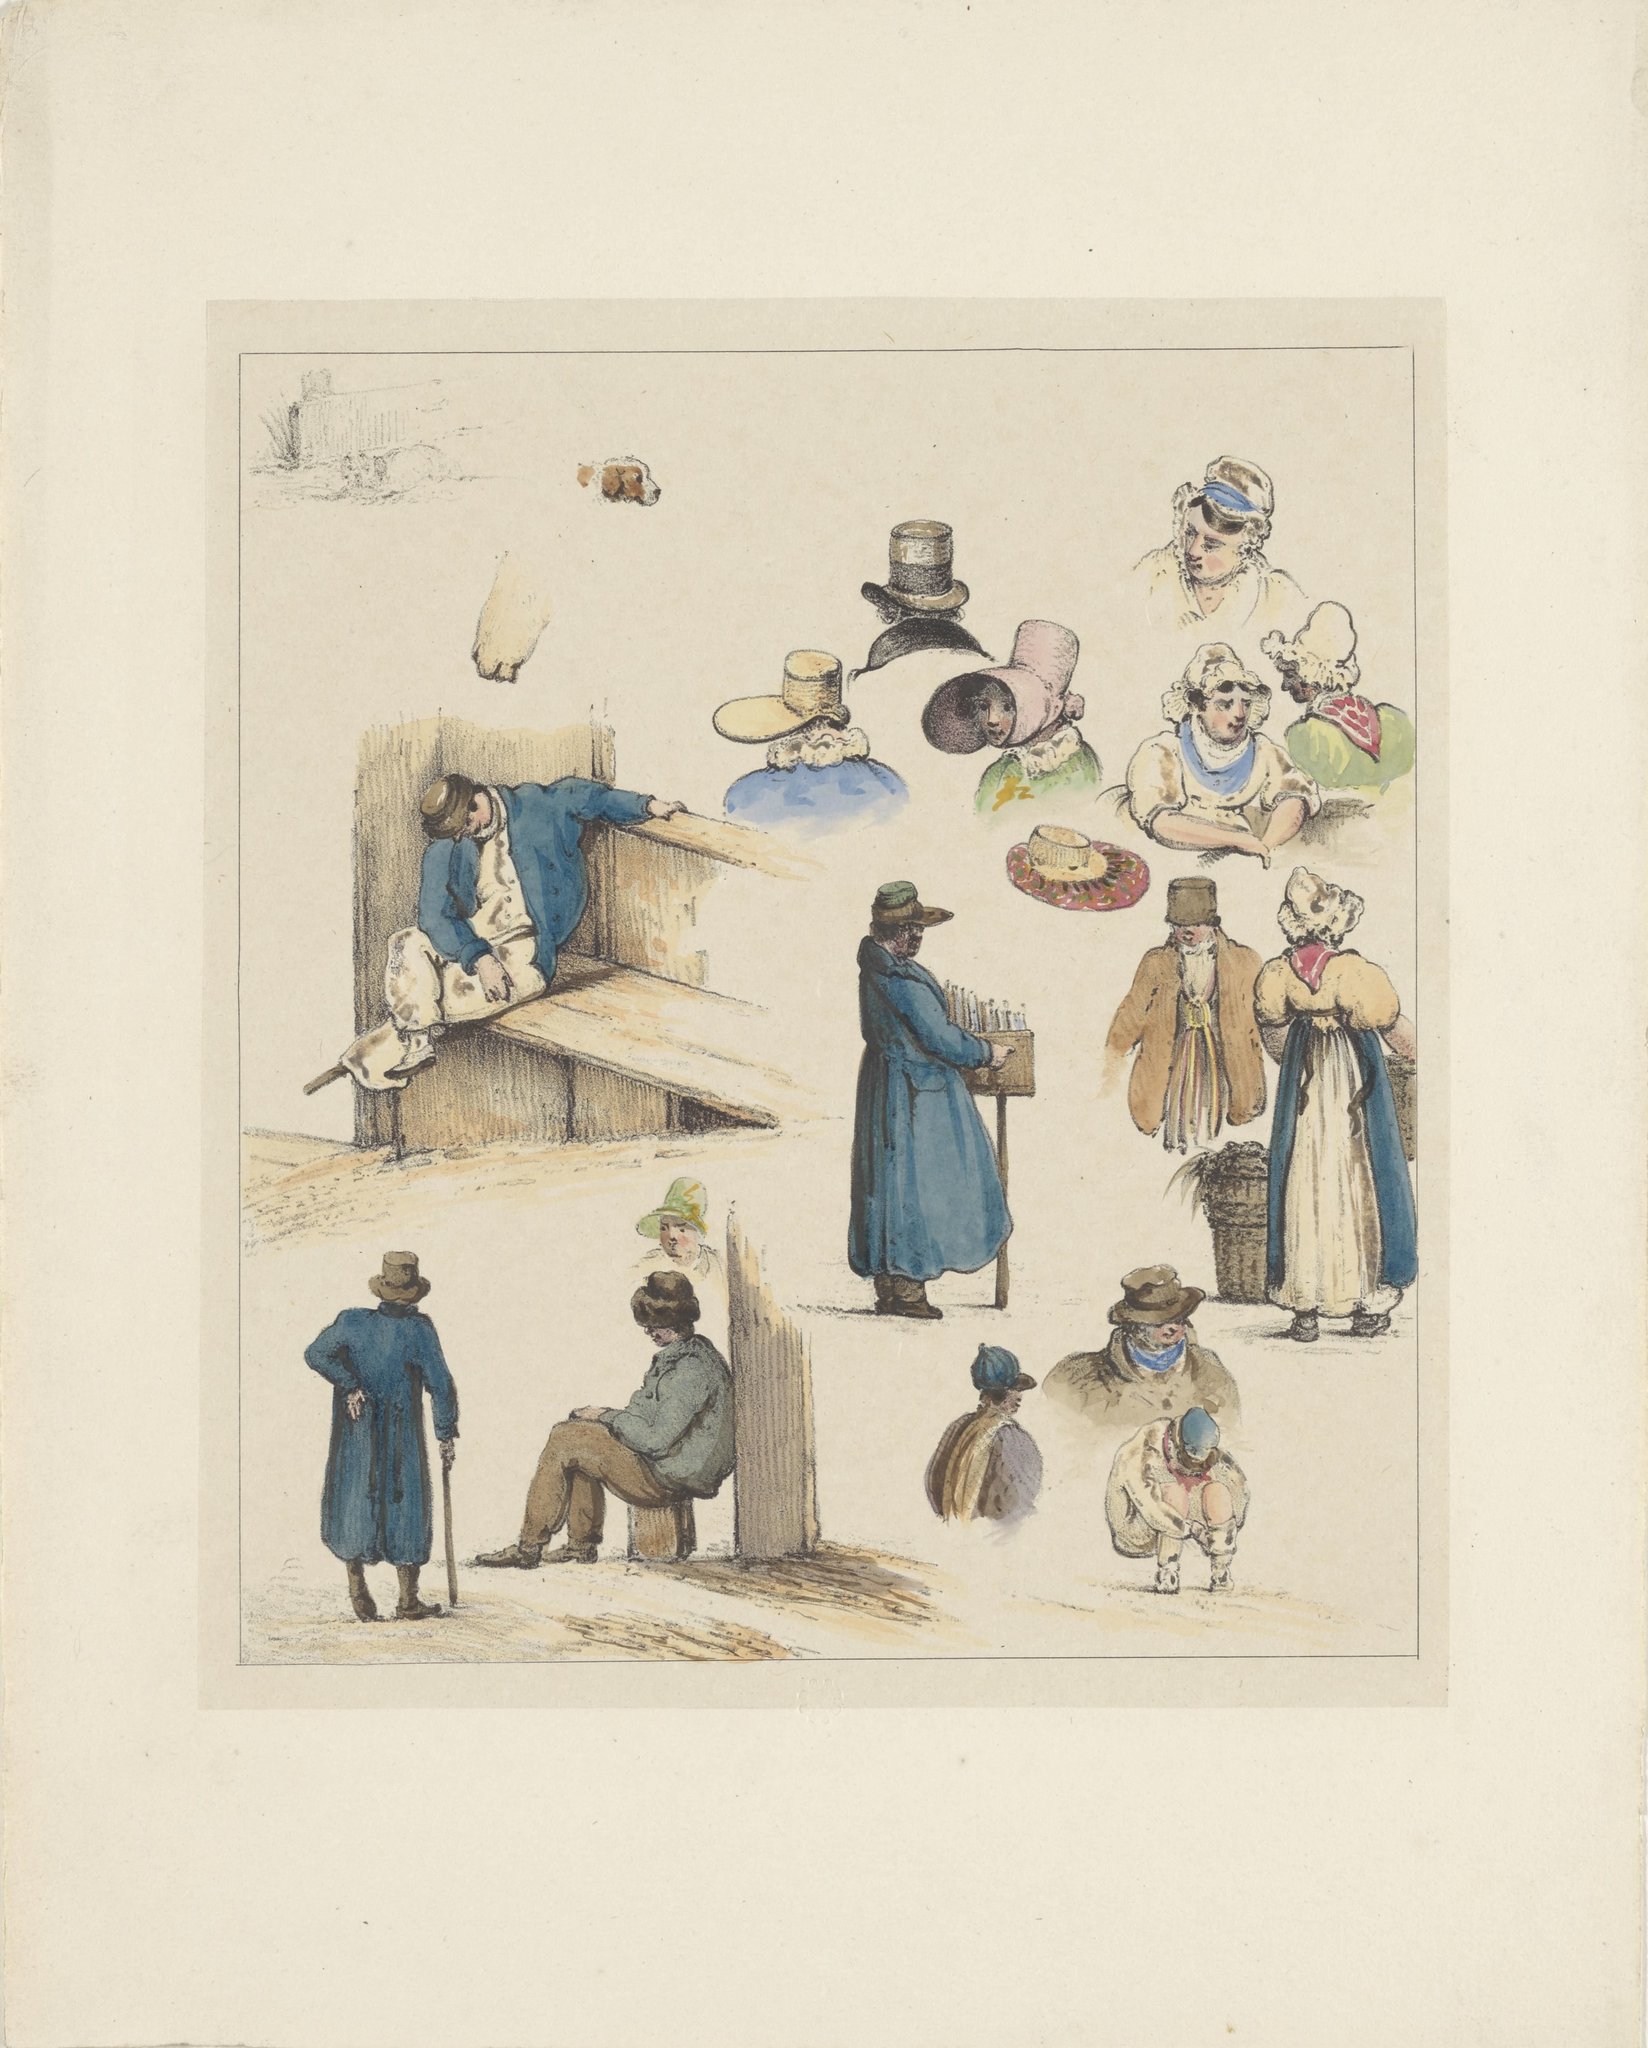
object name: print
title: Figuurstudies (eerste blad), 1833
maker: christiaan andriessen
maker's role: draughtsman, print maker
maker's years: 1775-1846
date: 1833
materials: paper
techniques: hand coloring, lithograph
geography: amsterdam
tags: street-trader, folk costume, regional costume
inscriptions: collector's mark:, collector's mark: Lugt 2228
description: Blad met figuren: links een man slapend op een houten bank en een man met een draaiorgel. Onderdeel van een serie van zes bladen met figuurstudies van Nederlandse klederdrachten, straatfiguren en gebuiken, 1833.